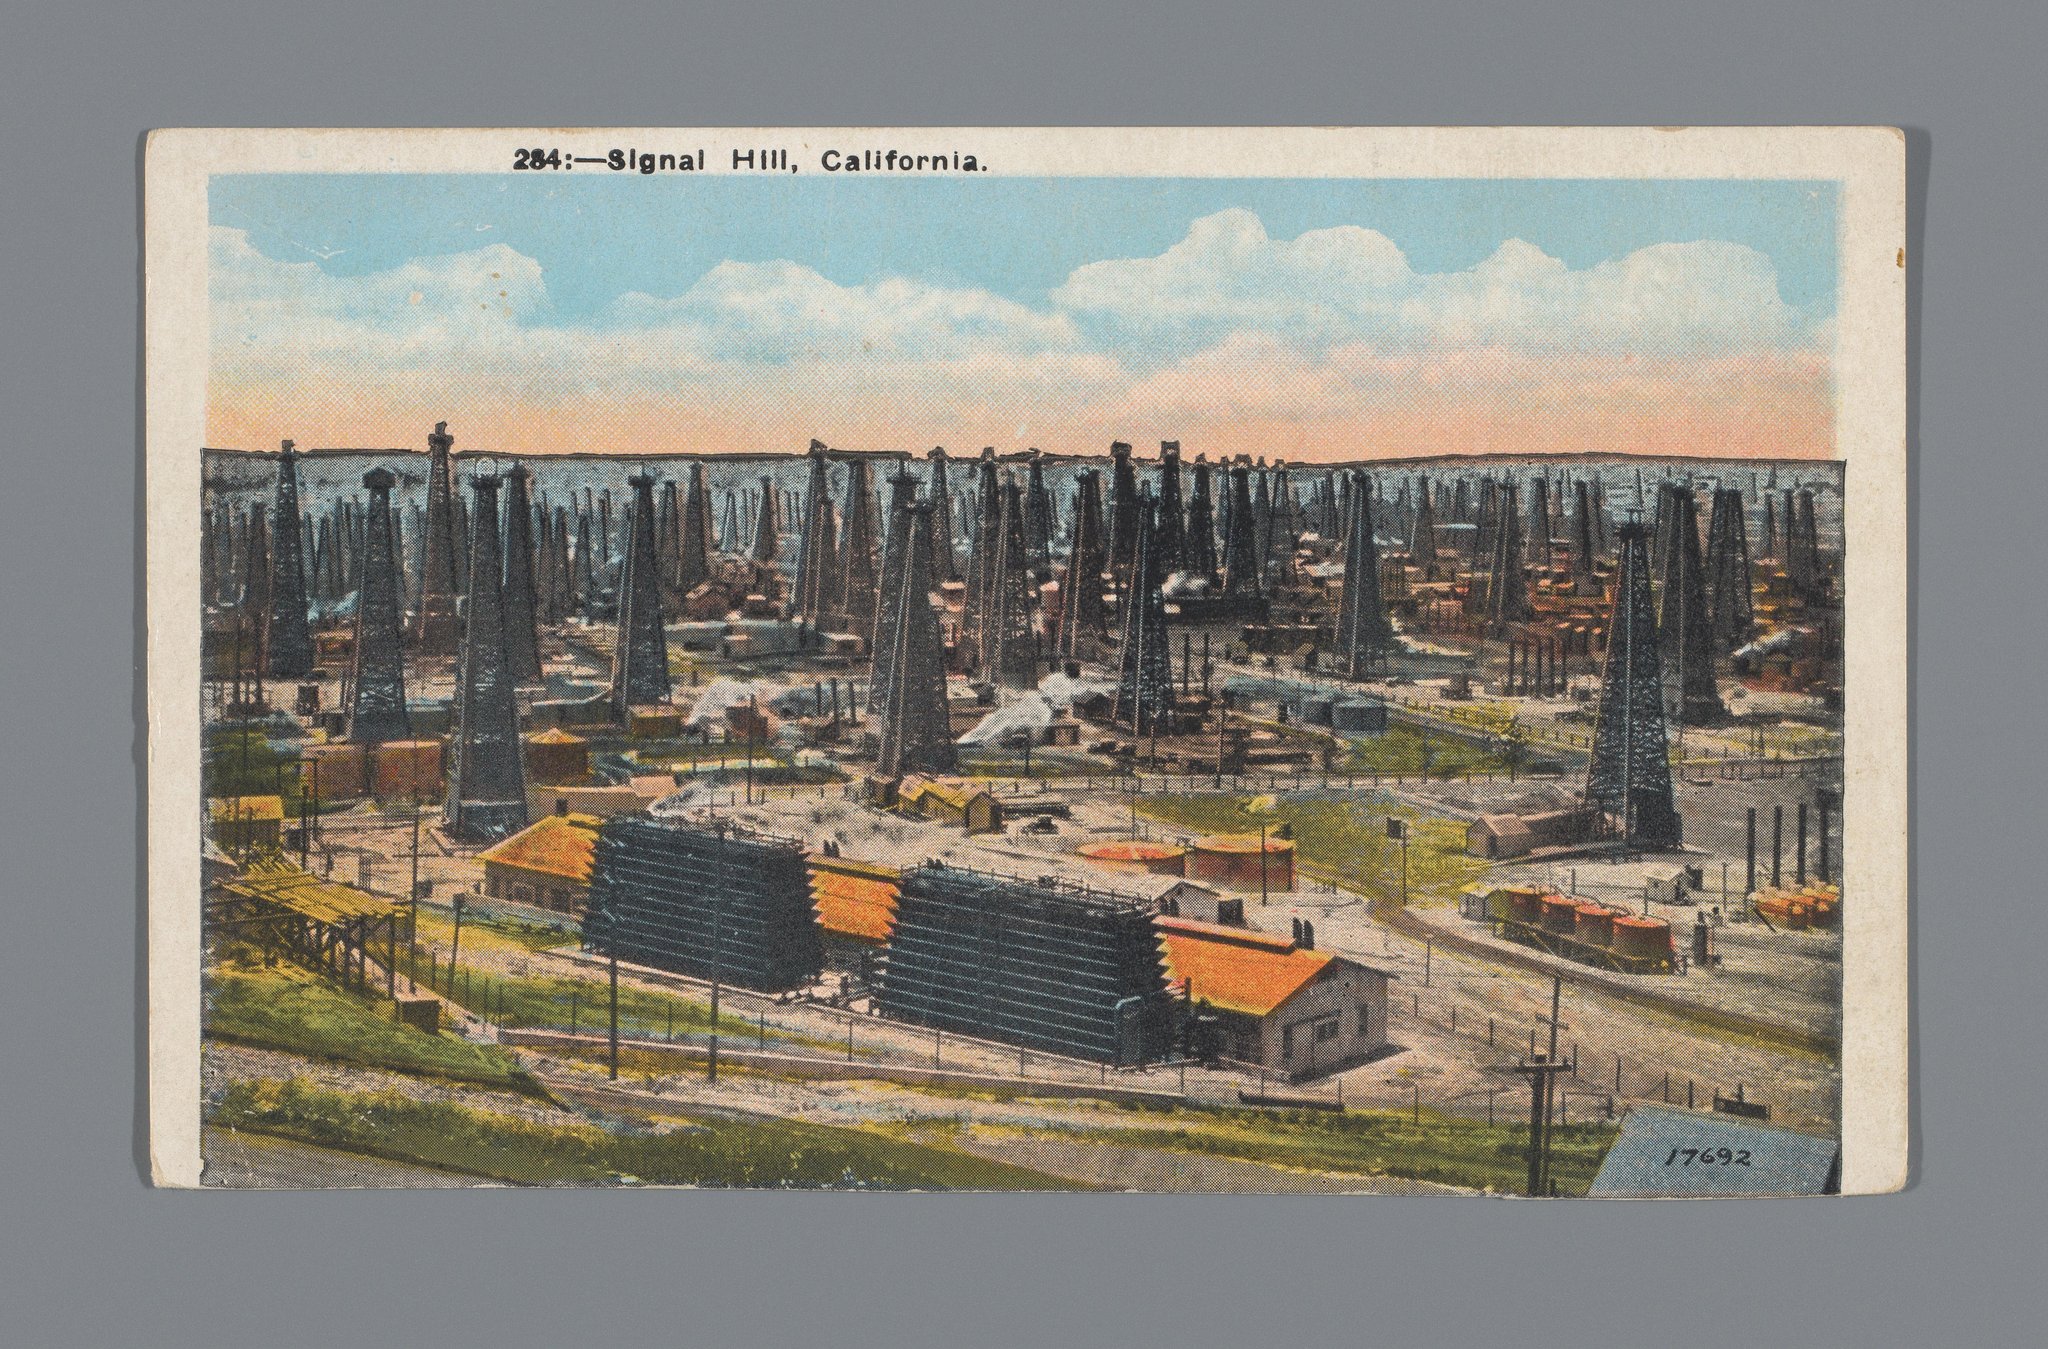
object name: ansichtkaart, prentbriefkaart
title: Olieveld in Signal Hill, Californië met boortorens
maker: Anonymous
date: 1914-1934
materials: paper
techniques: lithograph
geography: united states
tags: californië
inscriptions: inscription: ‘Pub. By the M. Kashower Co., Los Angeles, Cal.’, inscription: ‘284:-Signal Hill, California. / 17692’